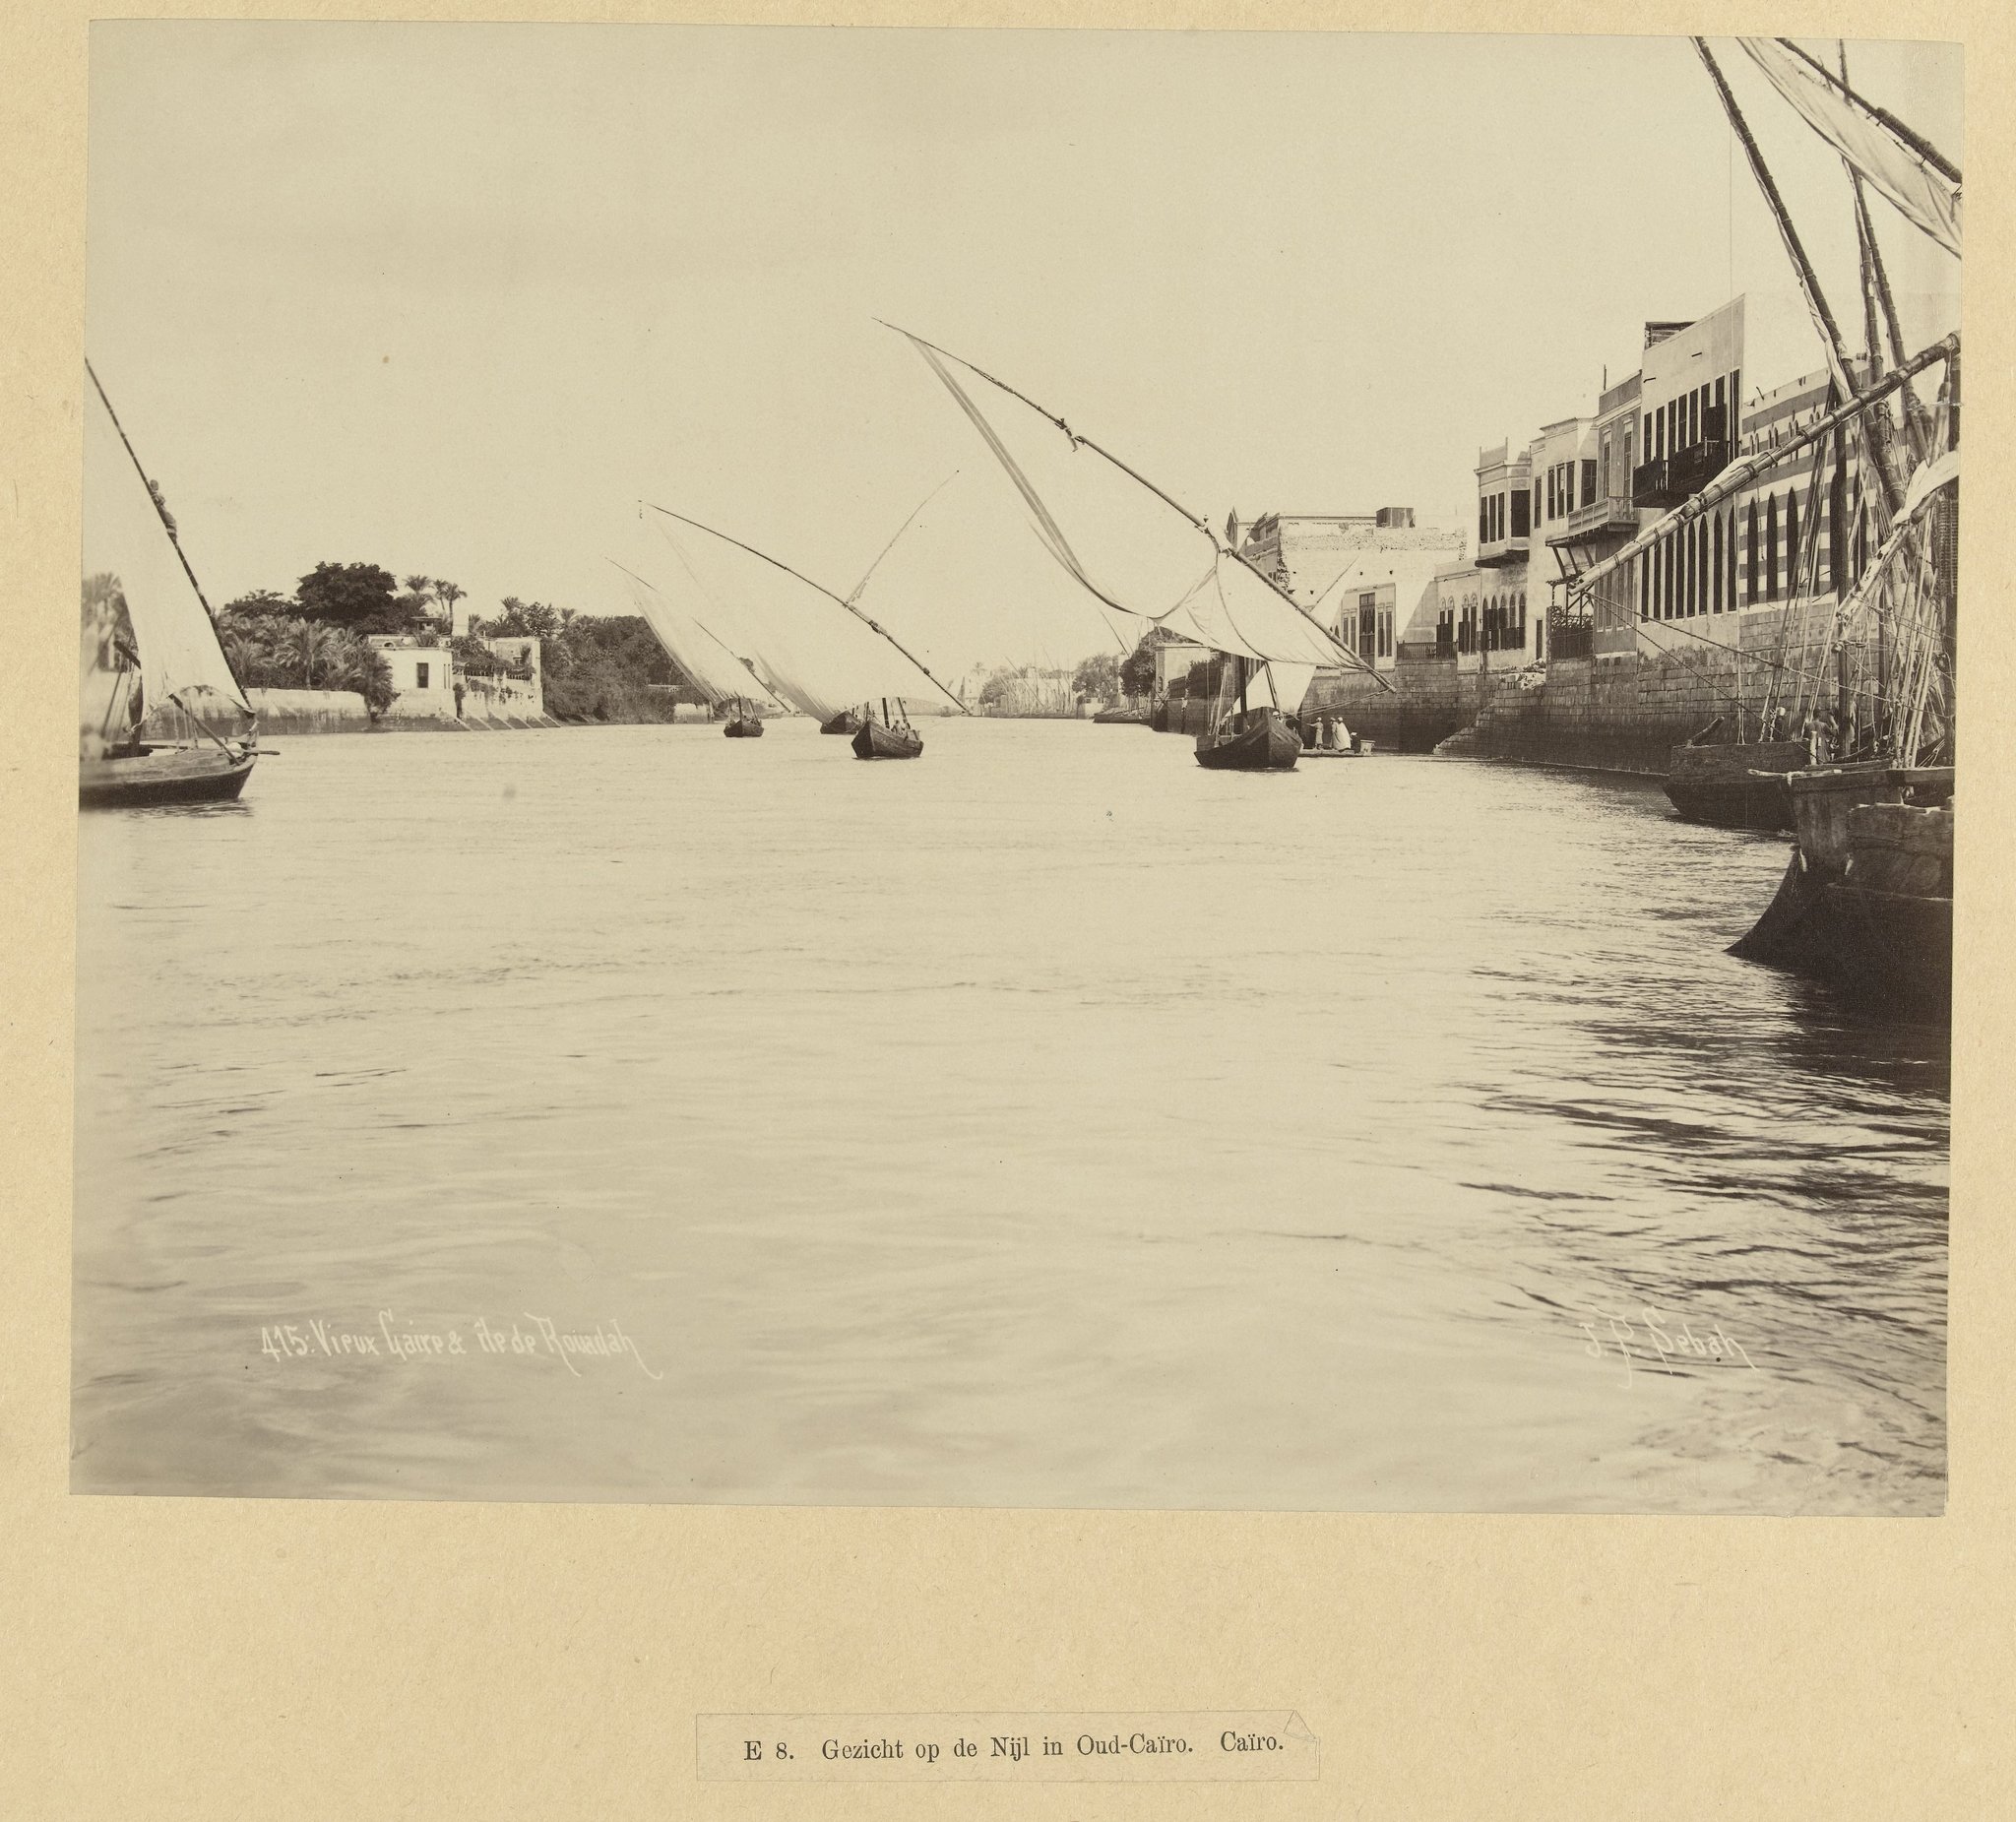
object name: photograph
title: Vieux Caire & île de Rouadah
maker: jean pascal sébah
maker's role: fotograaf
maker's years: 1872-1947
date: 1888-1895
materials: cardboard, paper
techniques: albumen print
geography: cairo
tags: sailing-ship, sailing-boat, river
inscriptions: stamp: ‘Gemeentelijke bibliotheek/ Rotterdam’, title: ‘R 8. Gezicht op de Nijl in Oud-Caïro. Caïro.’, check stamp: ‘Bristol/ L.M.’, number: ‘415’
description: Onderdeel van een groep door fotograaf Richard Polak op reis verzamelde foto’s. Deze foto is samen met andere op zijn reizen verzamelde foto's tentoongesteld bij de Rotterdamsche Kunstkring (1895), Arti en Amicitiae te Amsterdam (1897-1898?) en Societeit 't Collegie te Kampen (datum vooralsnog onbekend).